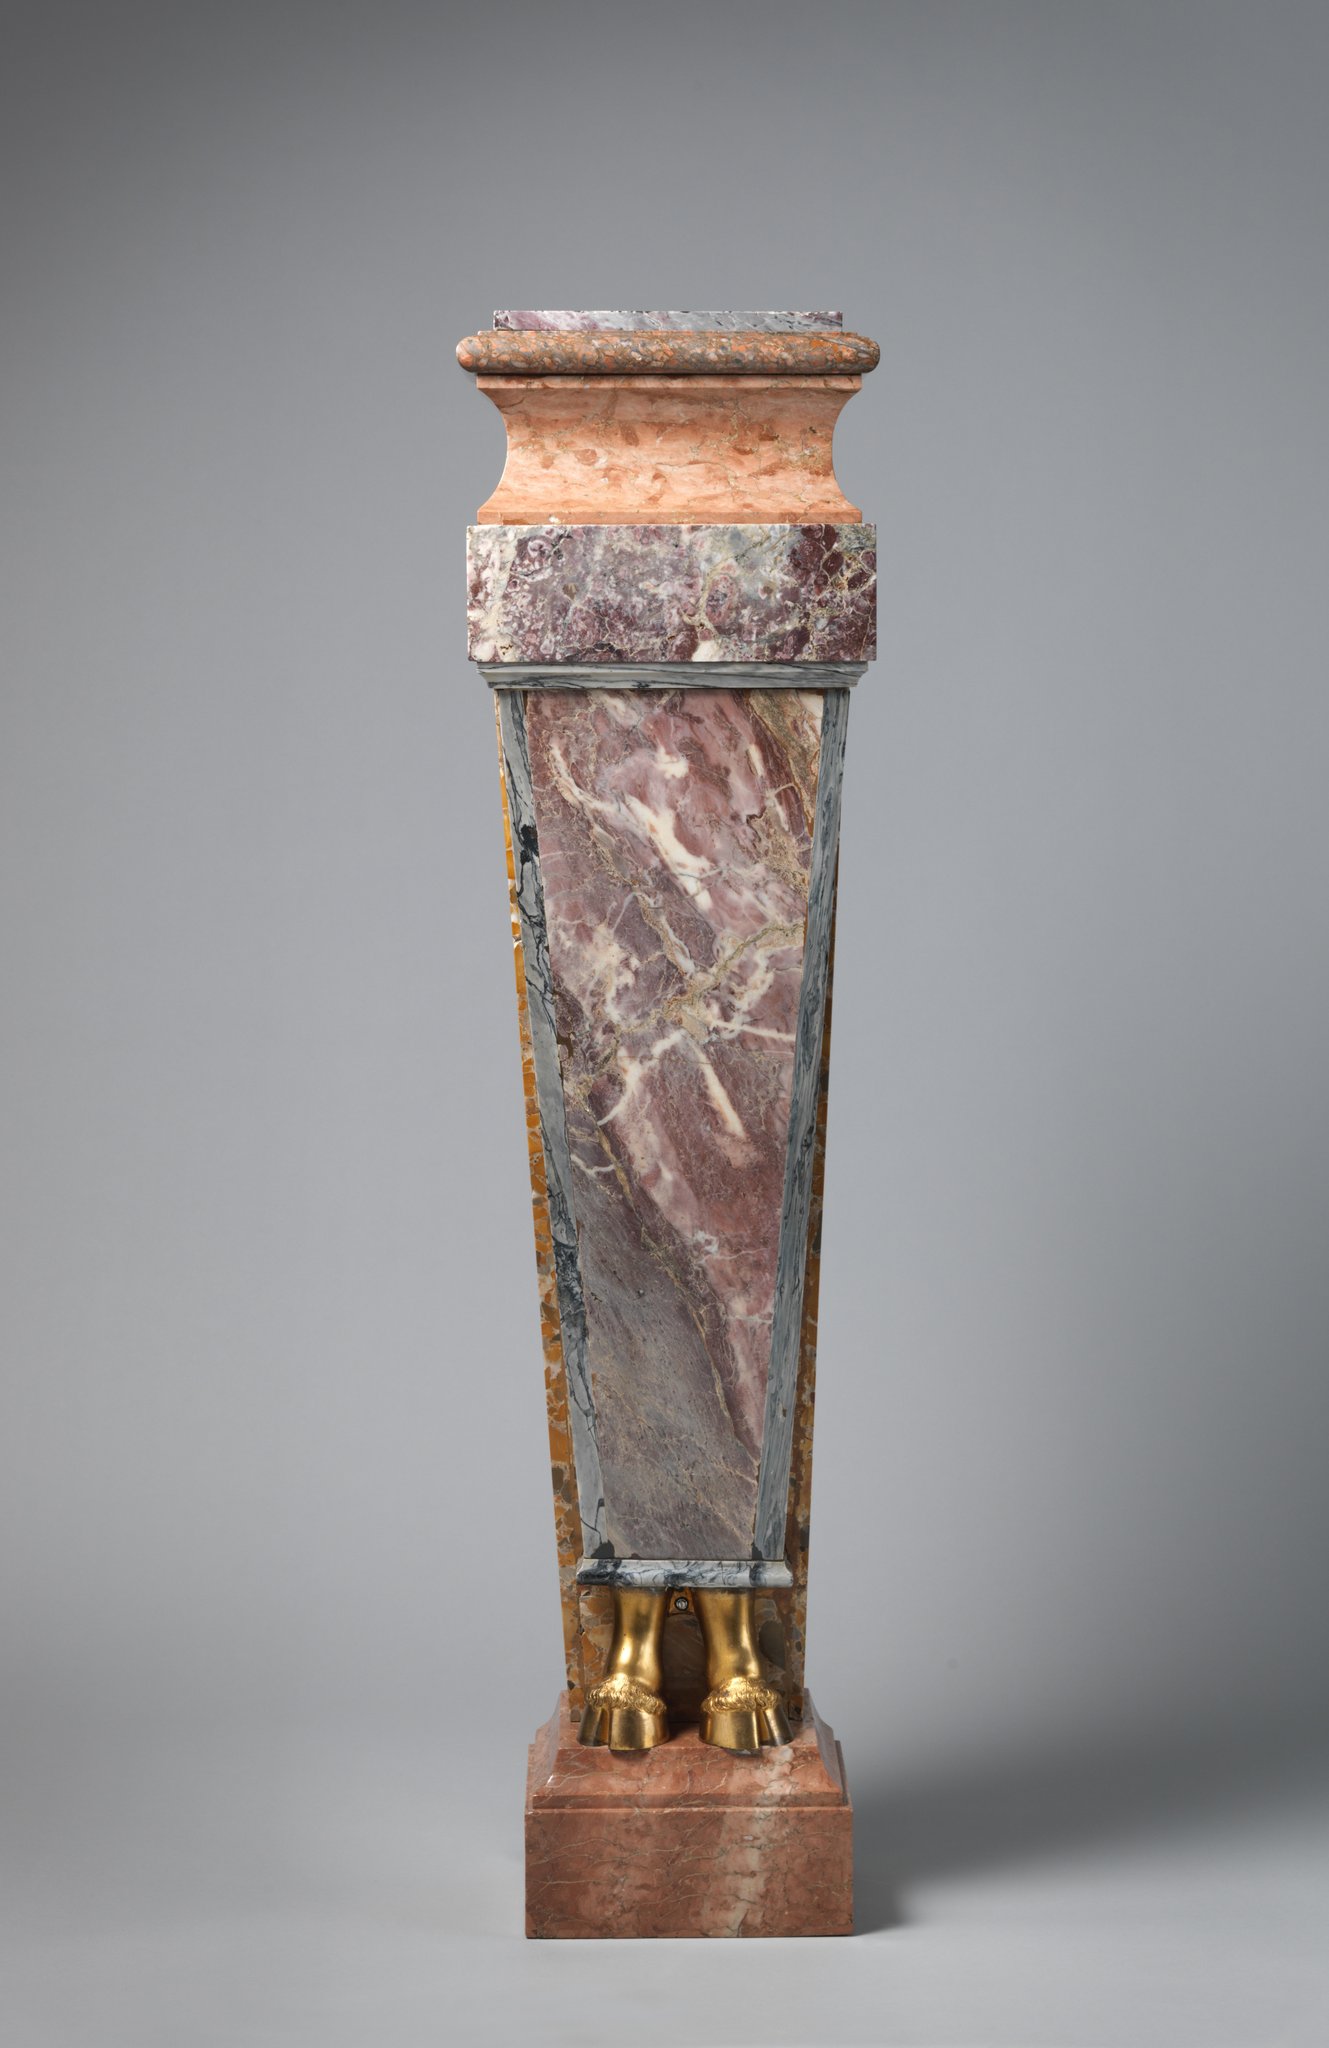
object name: pedestal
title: Pedestal with hooves (one of a pair)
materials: gilt, marble, metal